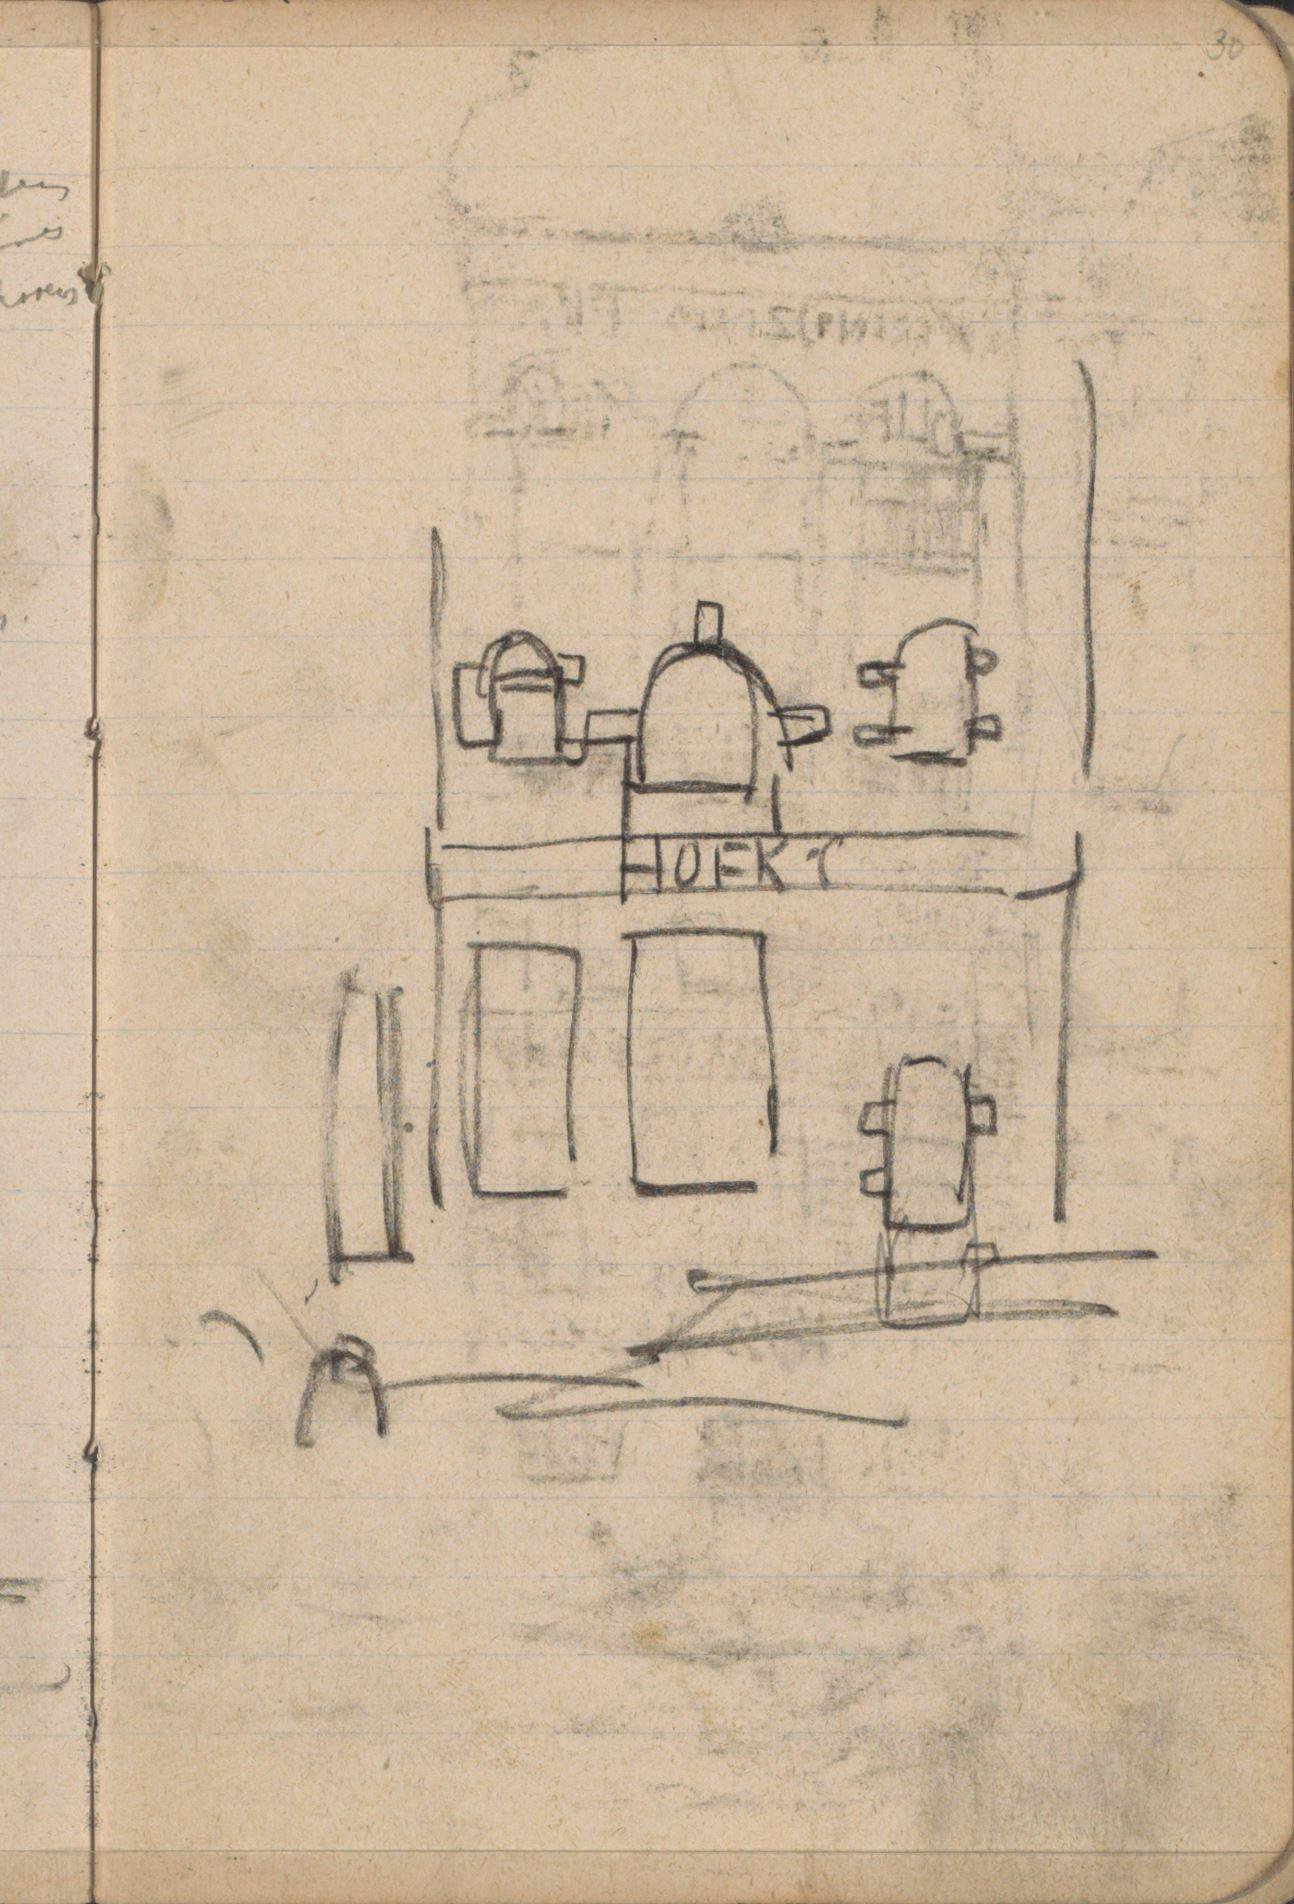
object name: sketchbook leaf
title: Gevel aan het Damrak te Amsterdam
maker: george hendrik breitner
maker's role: draughtsman, painter, print maker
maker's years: 1857-1923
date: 1902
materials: chalk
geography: amsterdam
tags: shop, store, canals, waters (in city), façade (of house or building)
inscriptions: inscription: ‘Hoek [...]’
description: Achterzijde van Warmoesstraat 46. Pagina 30 uit een schetsboek met 32 bladen.